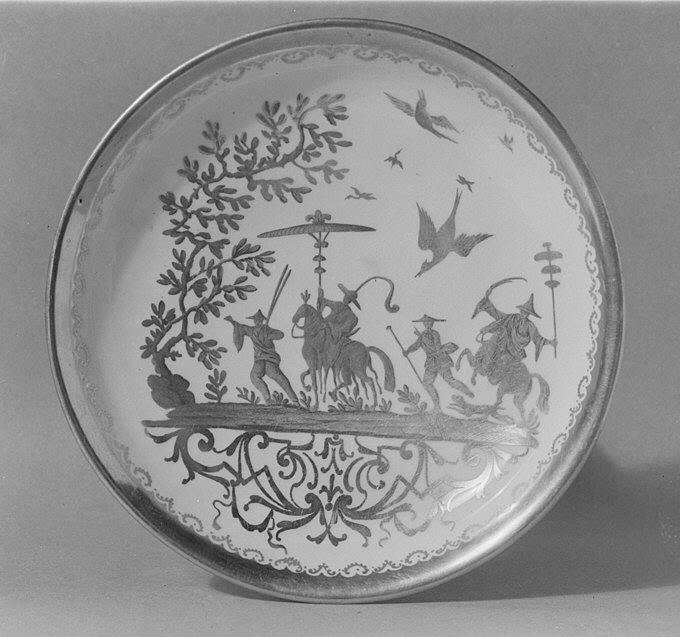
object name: dish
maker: meissen manufactory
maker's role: manufactory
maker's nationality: german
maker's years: 1710-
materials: hard paste porcelain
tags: birds,chinoiserie,men,horses